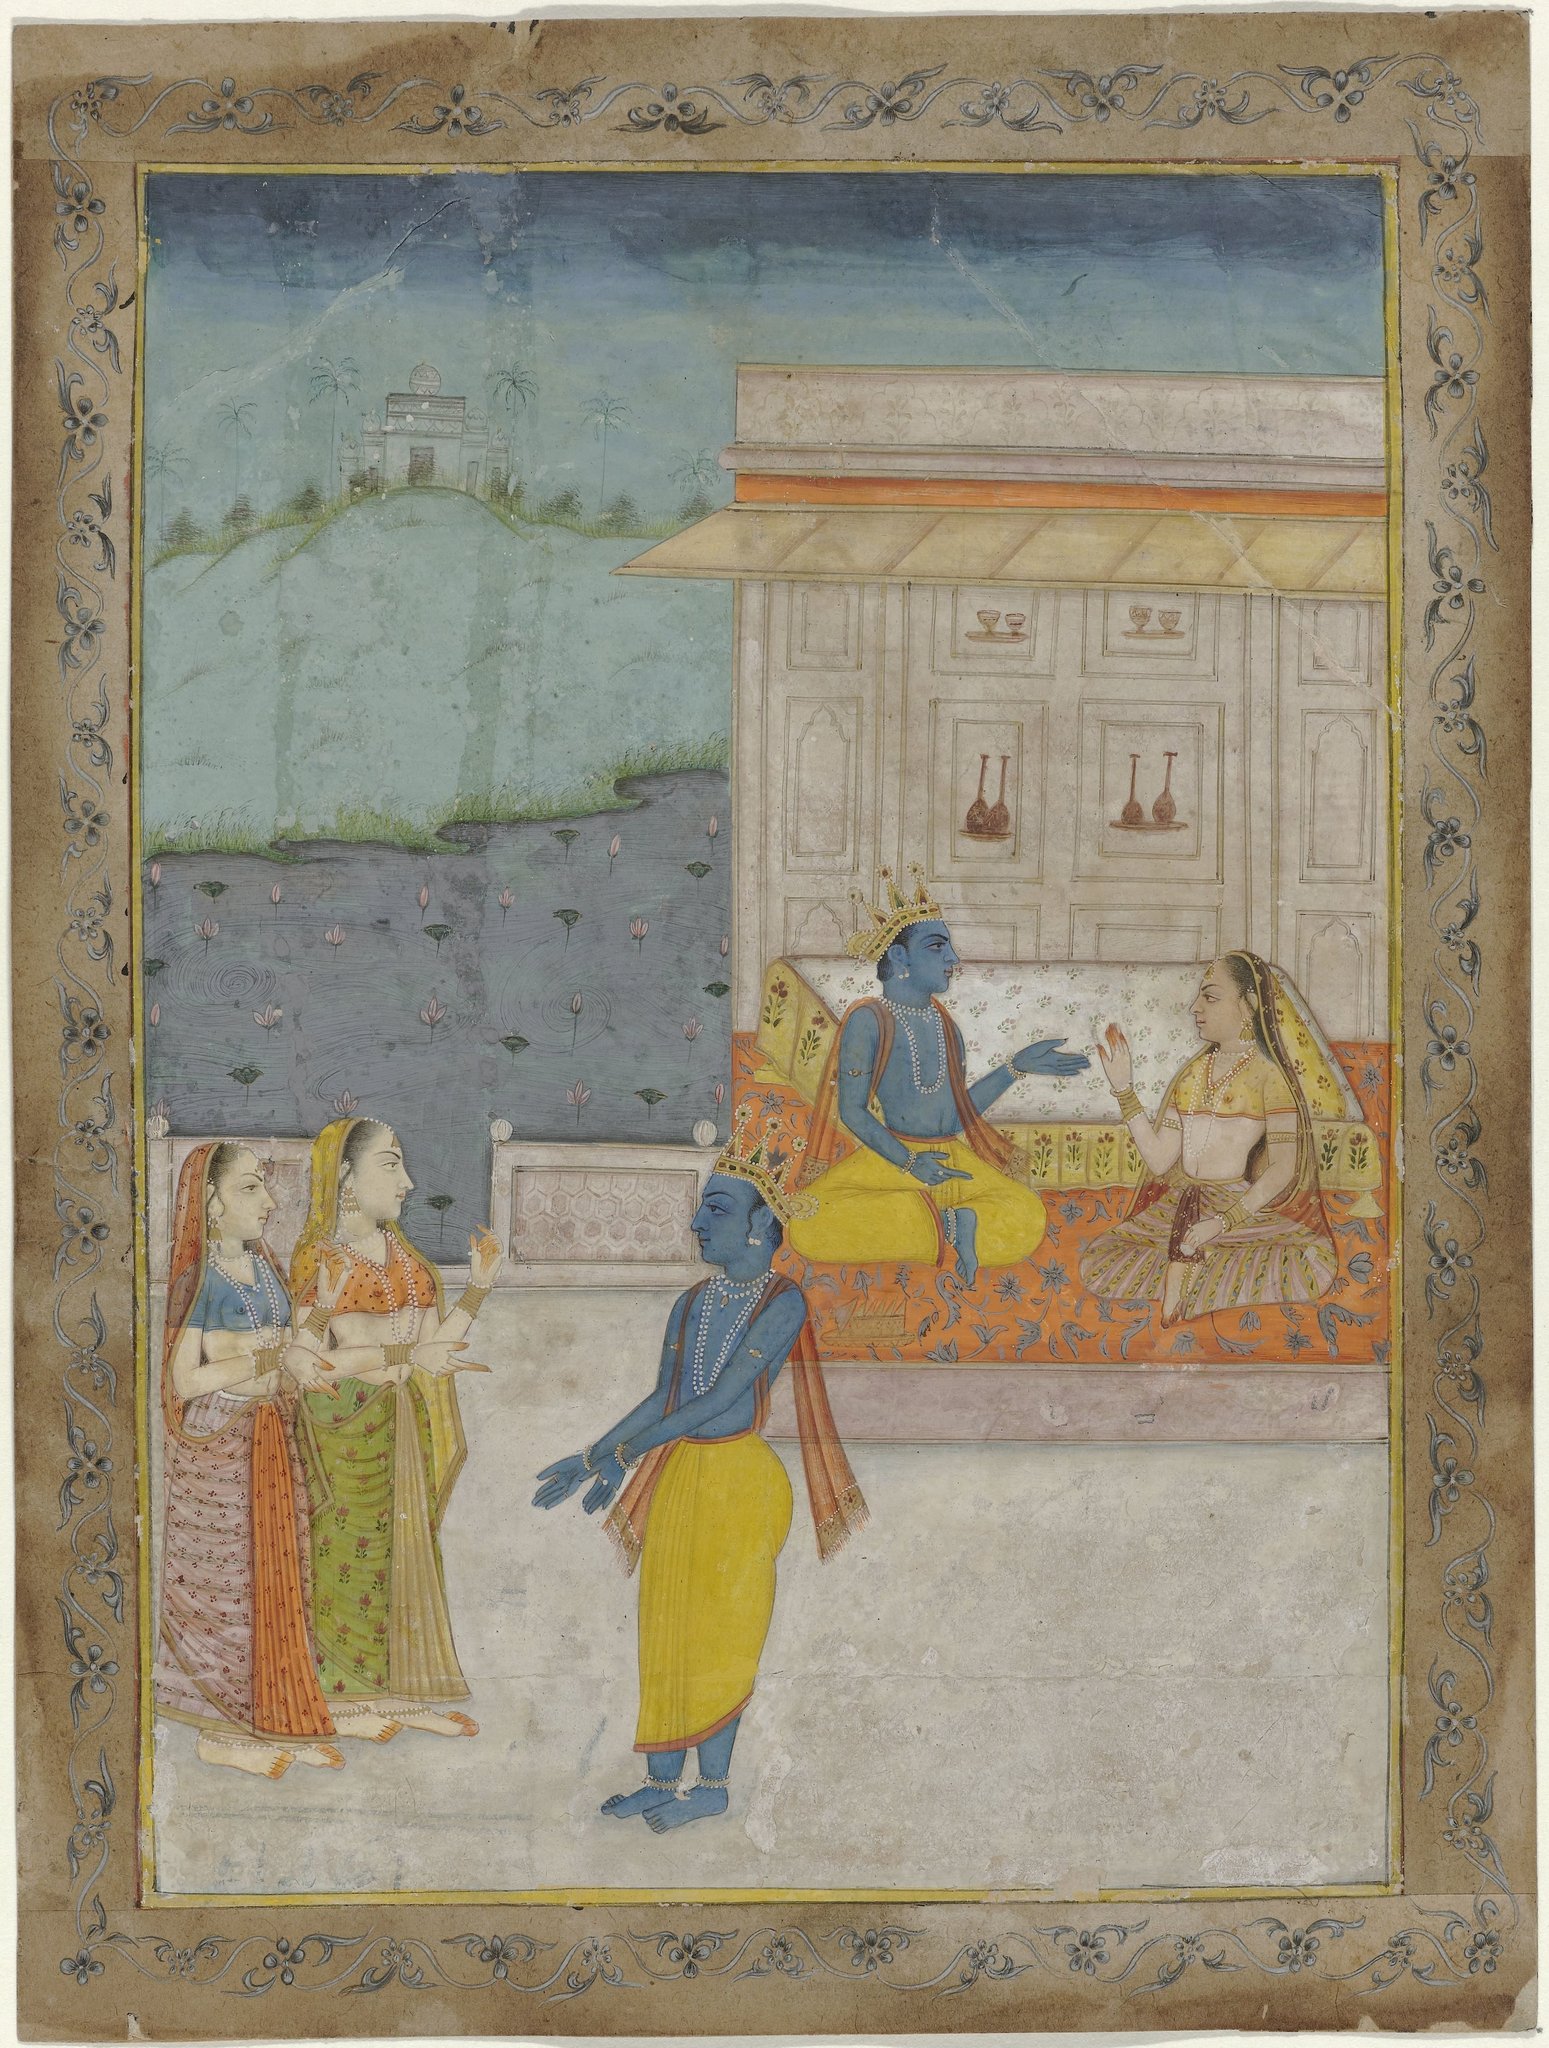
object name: drawing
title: Krishna en herderinnen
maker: Anonymous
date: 1700-1725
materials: paint, gouache, paper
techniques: brush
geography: bikaner